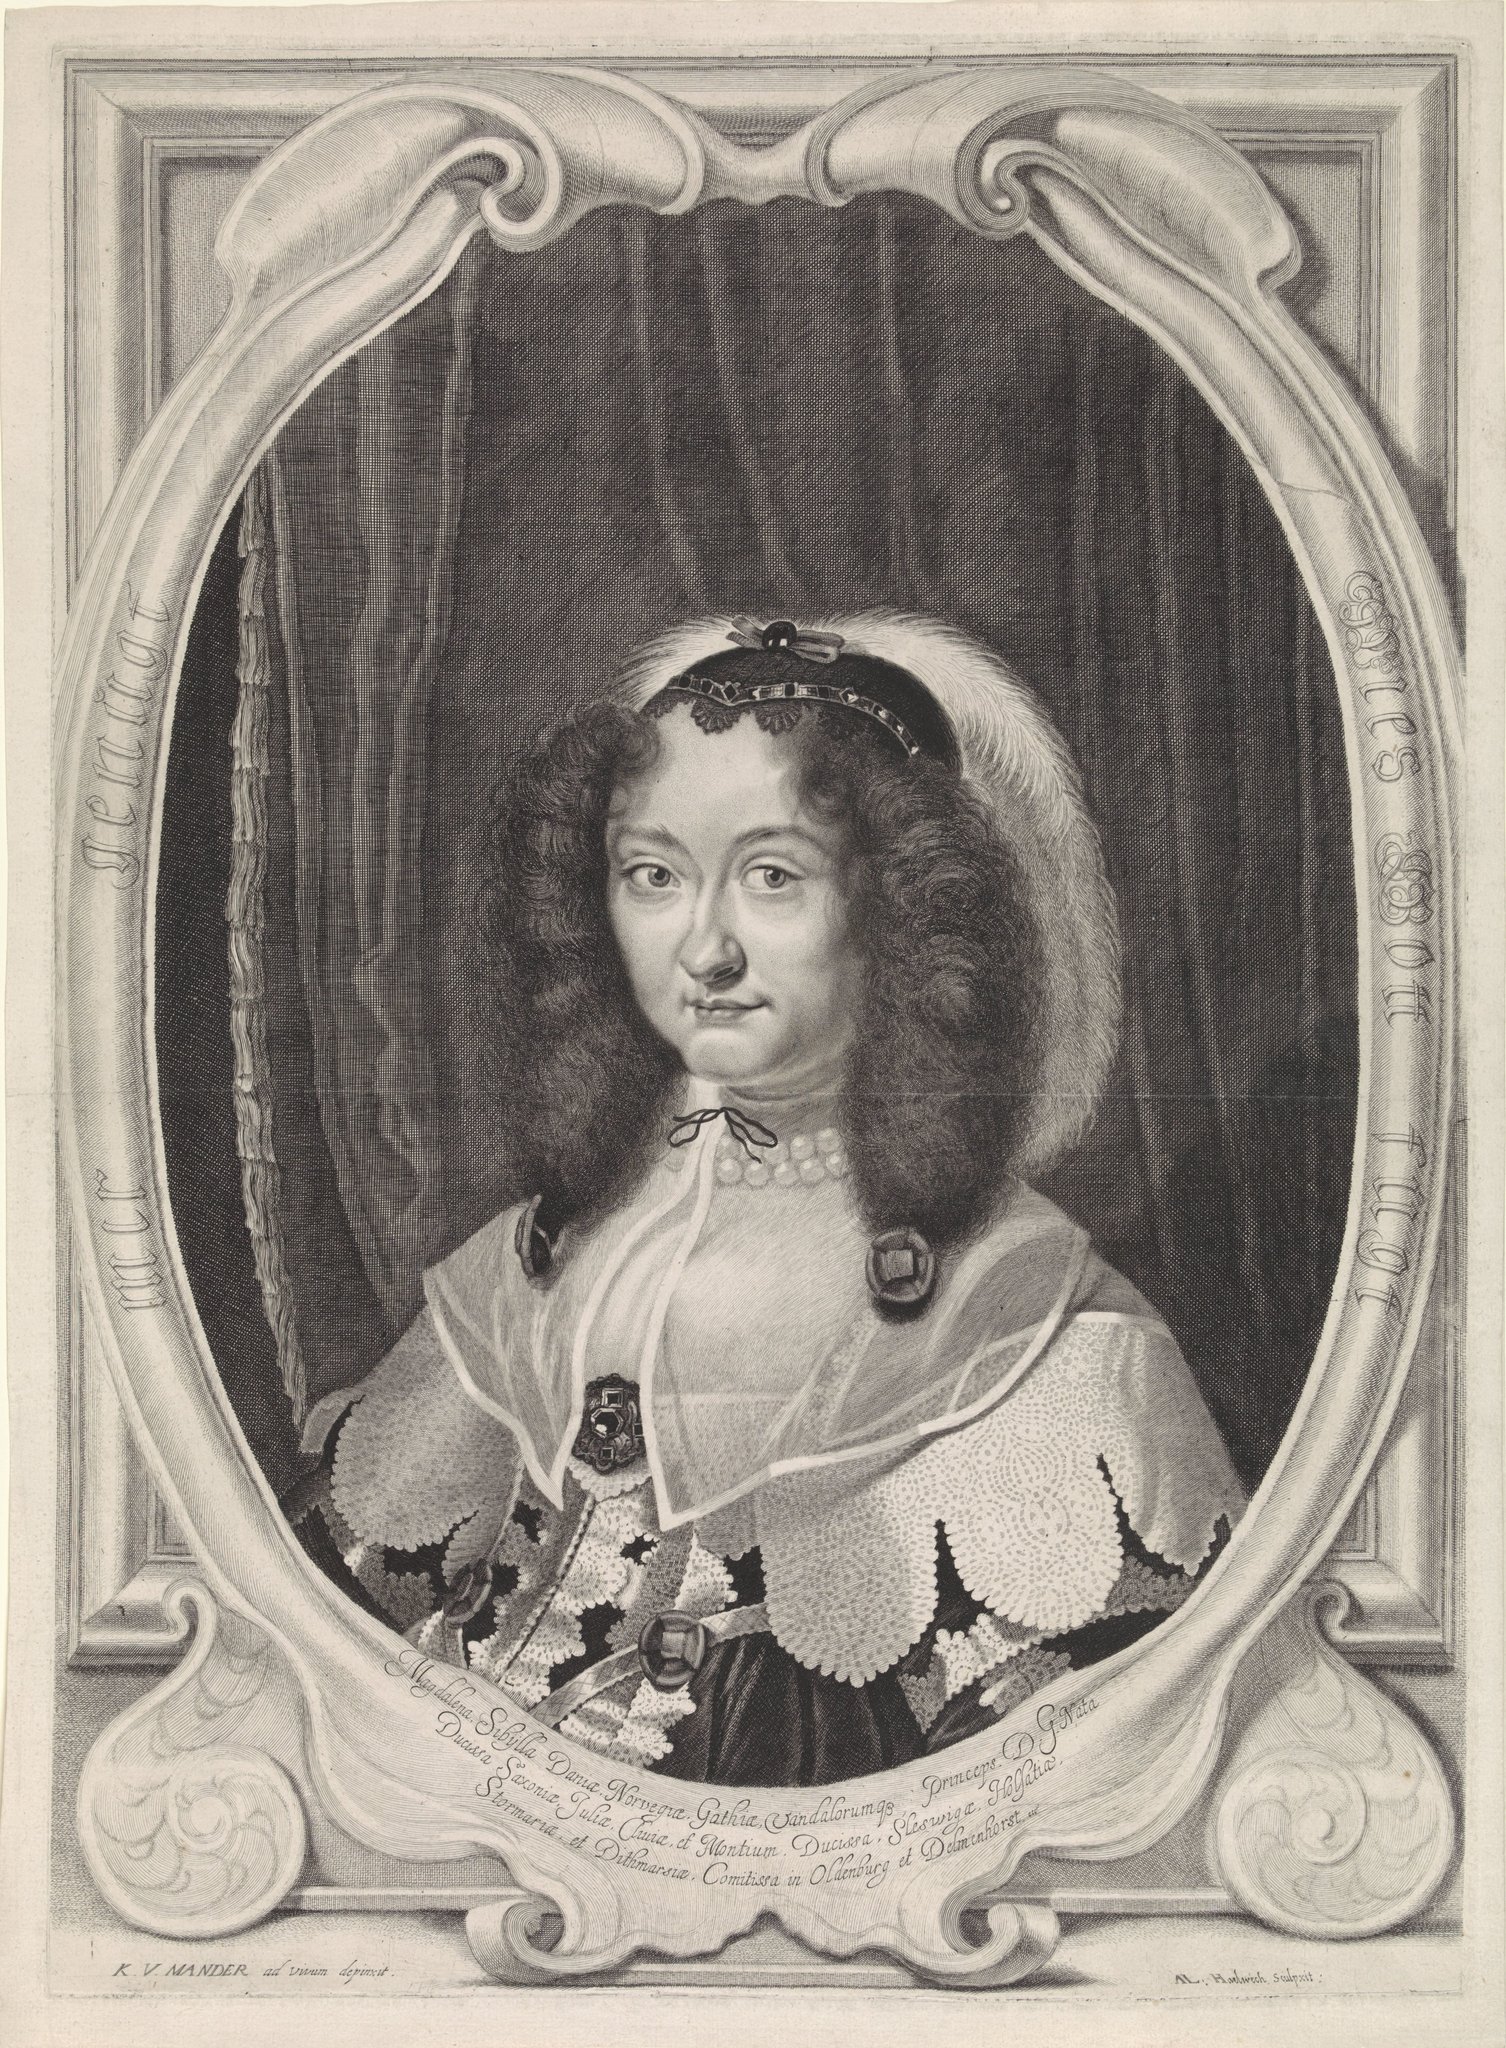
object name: print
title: Portret van Magdalena Sibylla van Saksen, kroonprinses van Denemarken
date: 1643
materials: paper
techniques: engraving, etching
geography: copenhagen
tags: head-gear: hat (+ women's clothes)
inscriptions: collector's mark: Lugt 1060, collector's mark: Lugt 119, collector's mark: Lugt 654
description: Portret van Magdalena Sibylla van Saksen, kroonprinses van Denemarken, in een ovaal cartouche. Op haar hoofd een kapje met een veer.